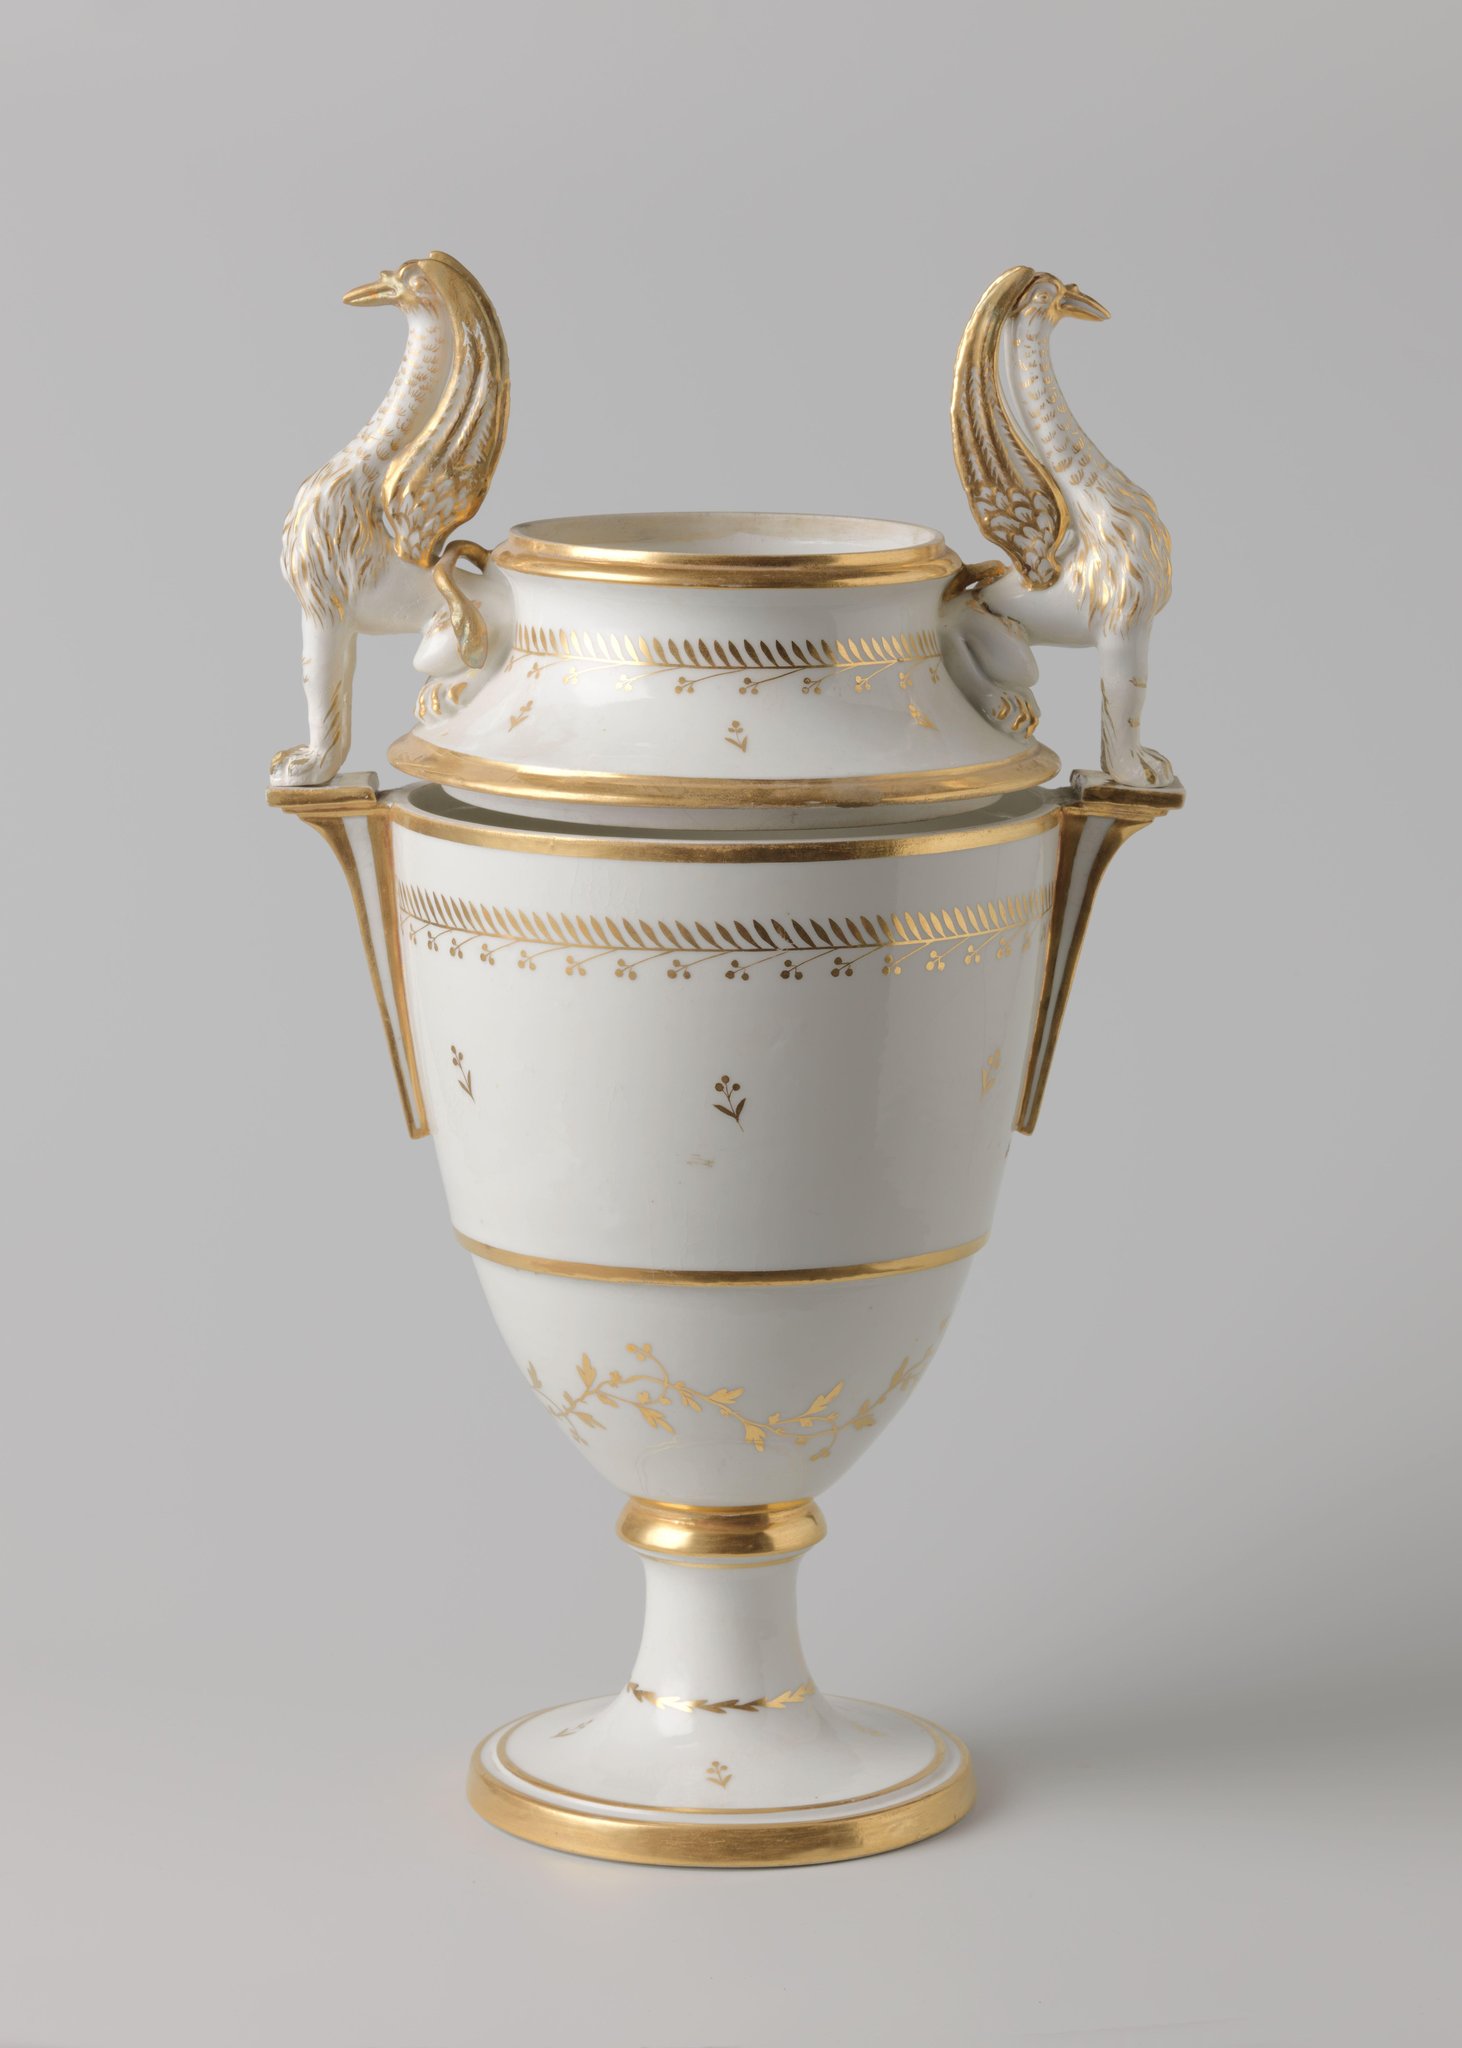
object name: cuppa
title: De cuppa van een kastanjevaas versierd met griffioenen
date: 1810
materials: porcelain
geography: netherlands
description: De cuppa van een kastanjevaas versierd goudkleurige randen en bladranken.